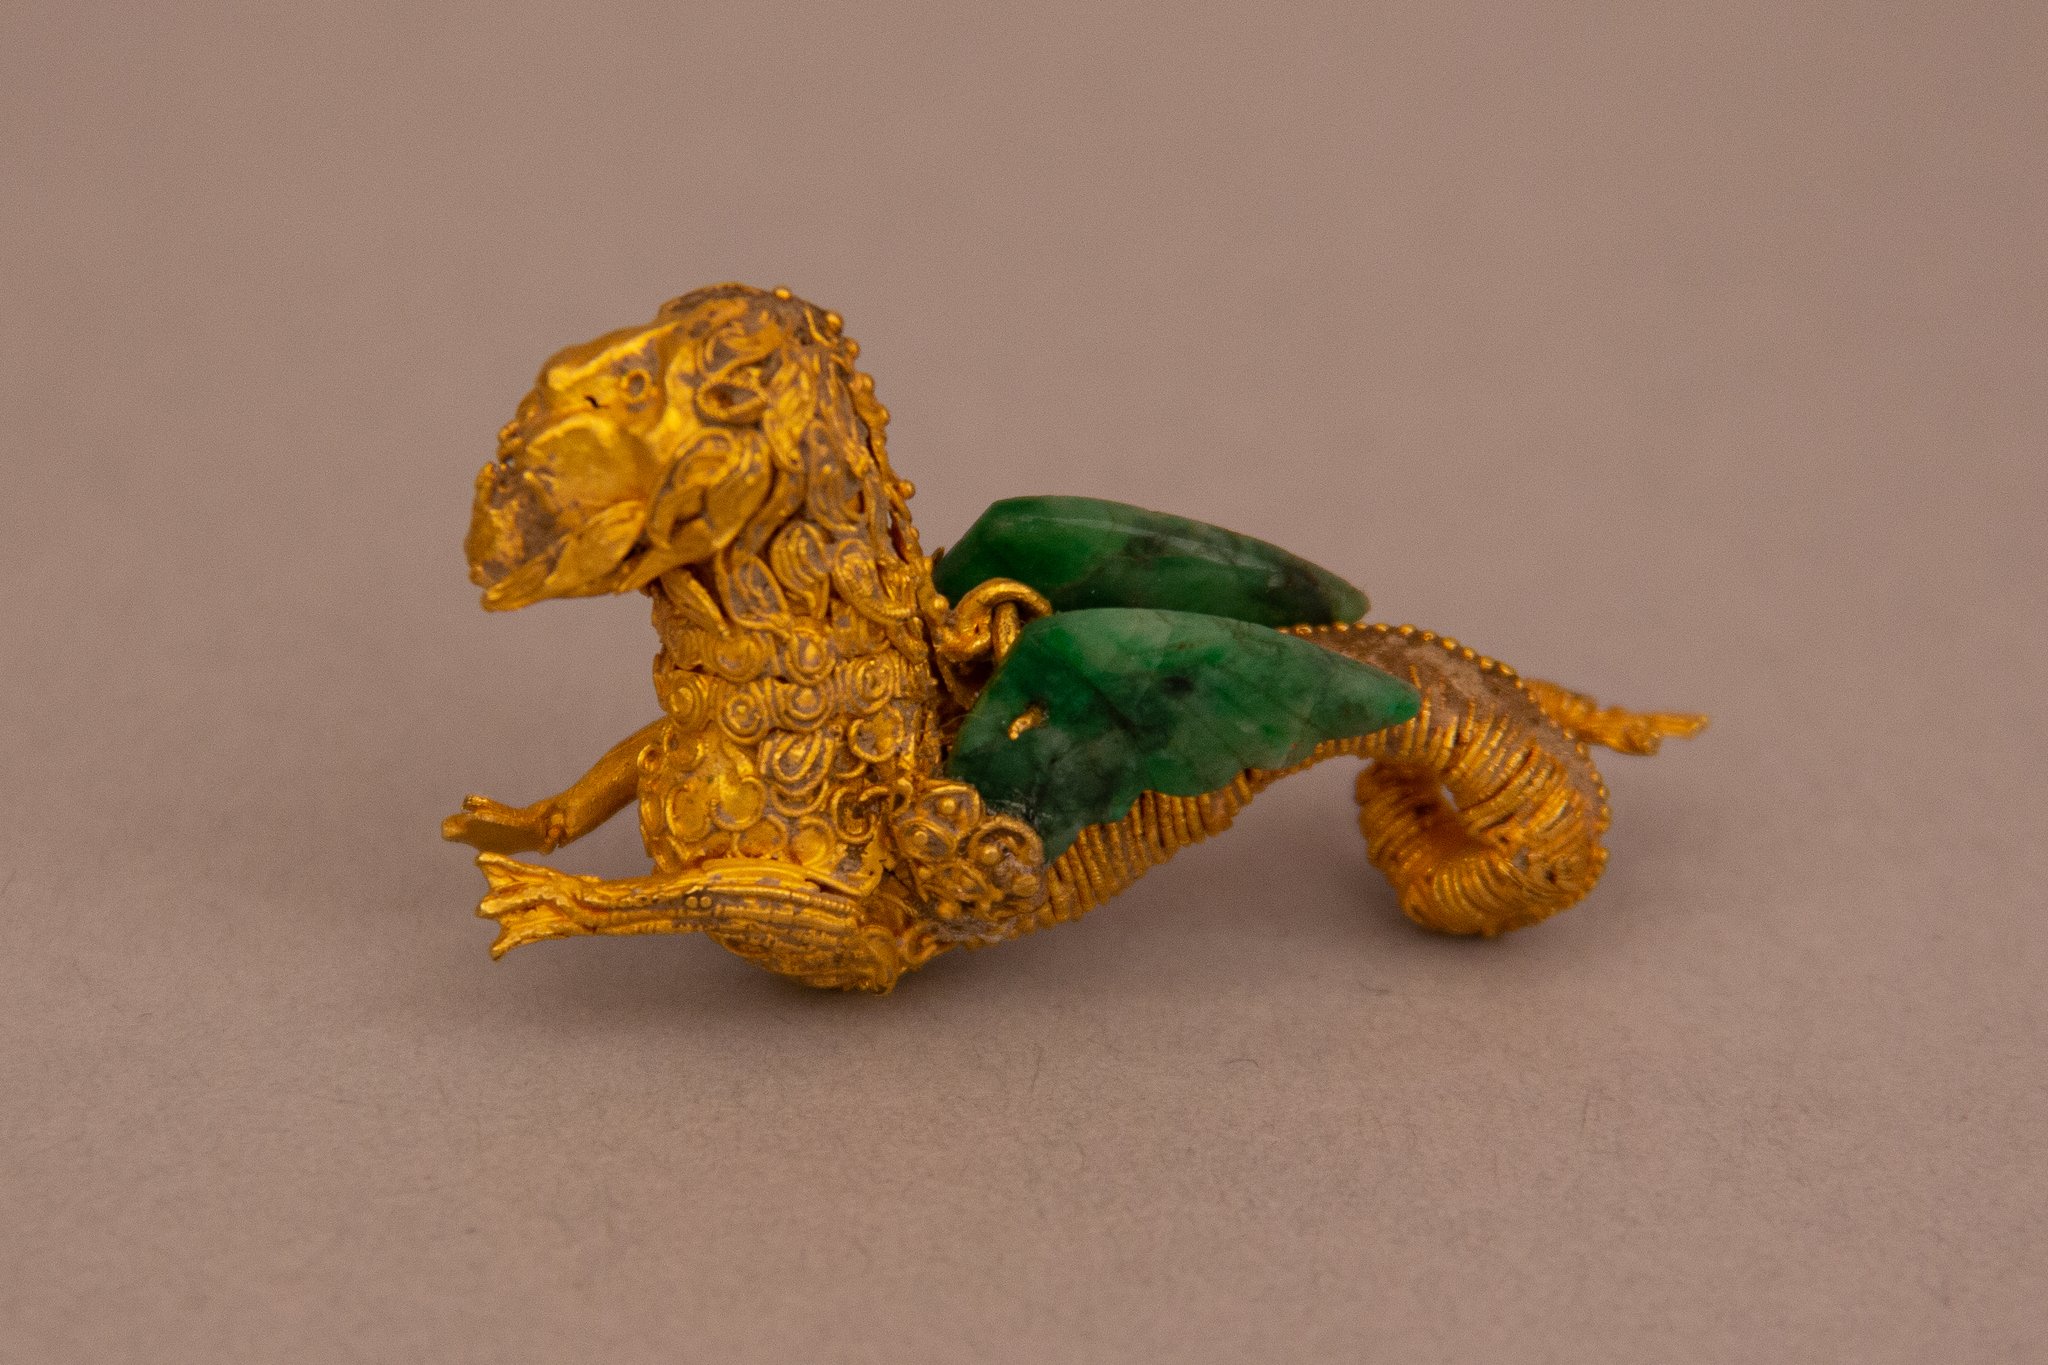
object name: pendant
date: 1101-1300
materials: gold, jade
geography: iran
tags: dragons